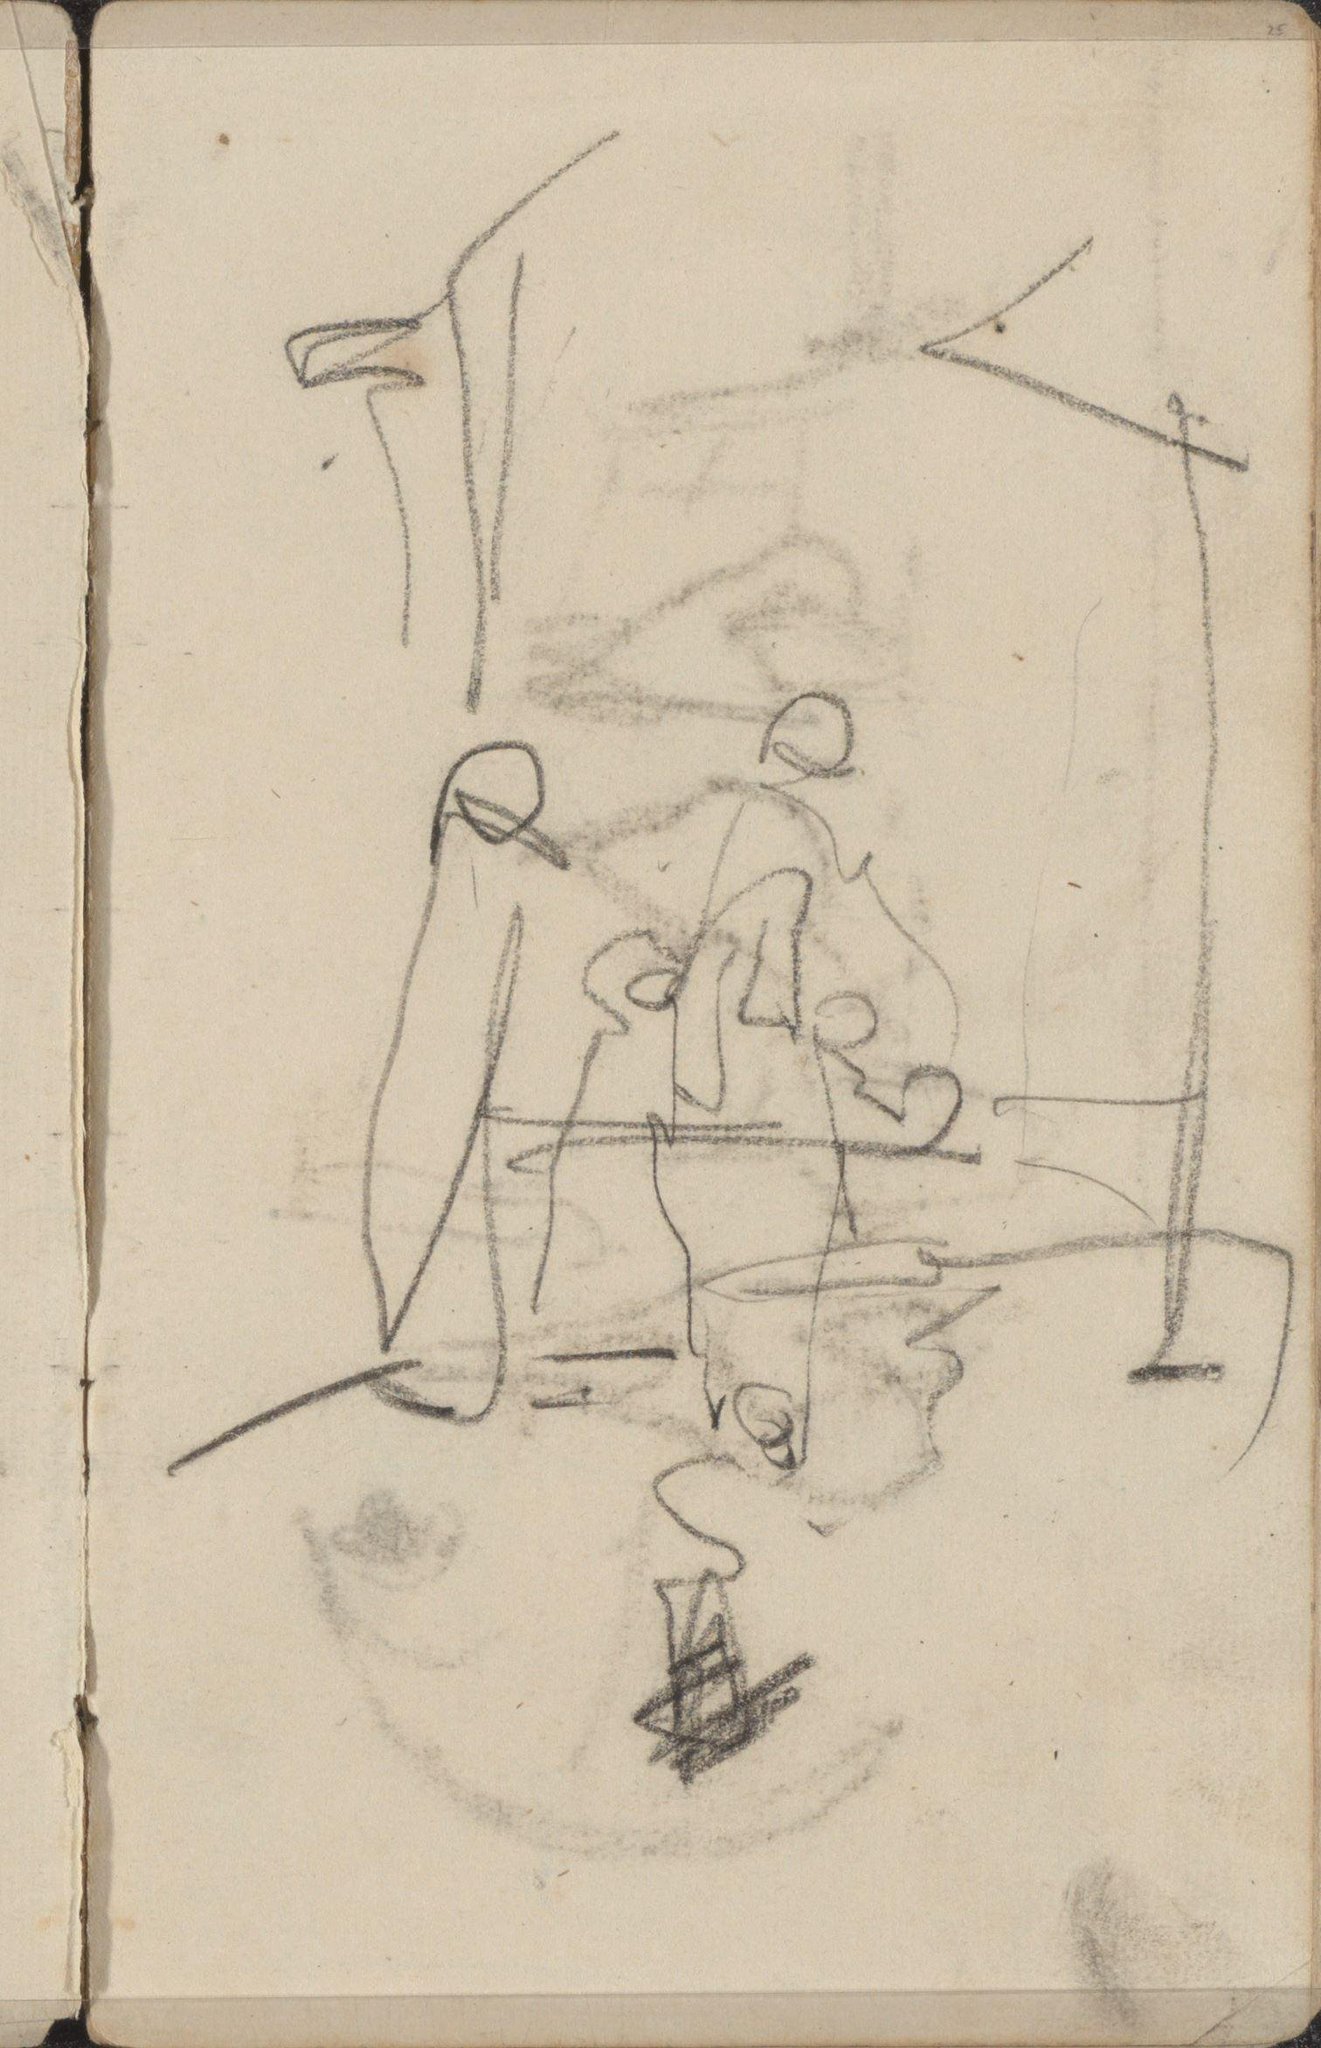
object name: sketchbook leaf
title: Figuren, mogelijk op straat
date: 1881-1883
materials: chalk, paper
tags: family group, especially parents with their child(ren), street (+ city(-scape) with figures, staffage)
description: Pagina 25 uit een schetsboek met 29 bladen.